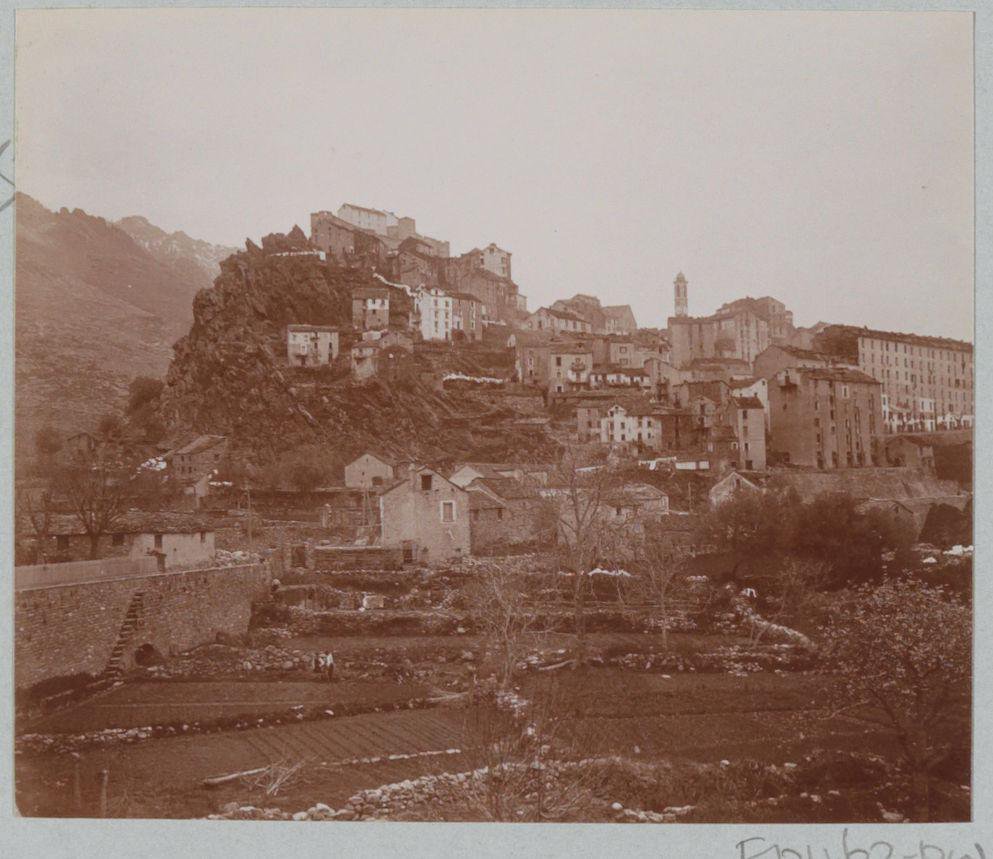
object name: photograph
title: Gezicht op Corte in de bergen van Corsica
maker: Anonymous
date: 1905-1910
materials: paper, photographic support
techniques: gelatin silver print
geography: corsica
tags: prospect of village, silhouette of village, rock-formations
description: Onderdeel van Fotoalbum van een Franse amateurfotograaf met bezienswaardigheden in Frankrijk, Zwitserland en Italië.